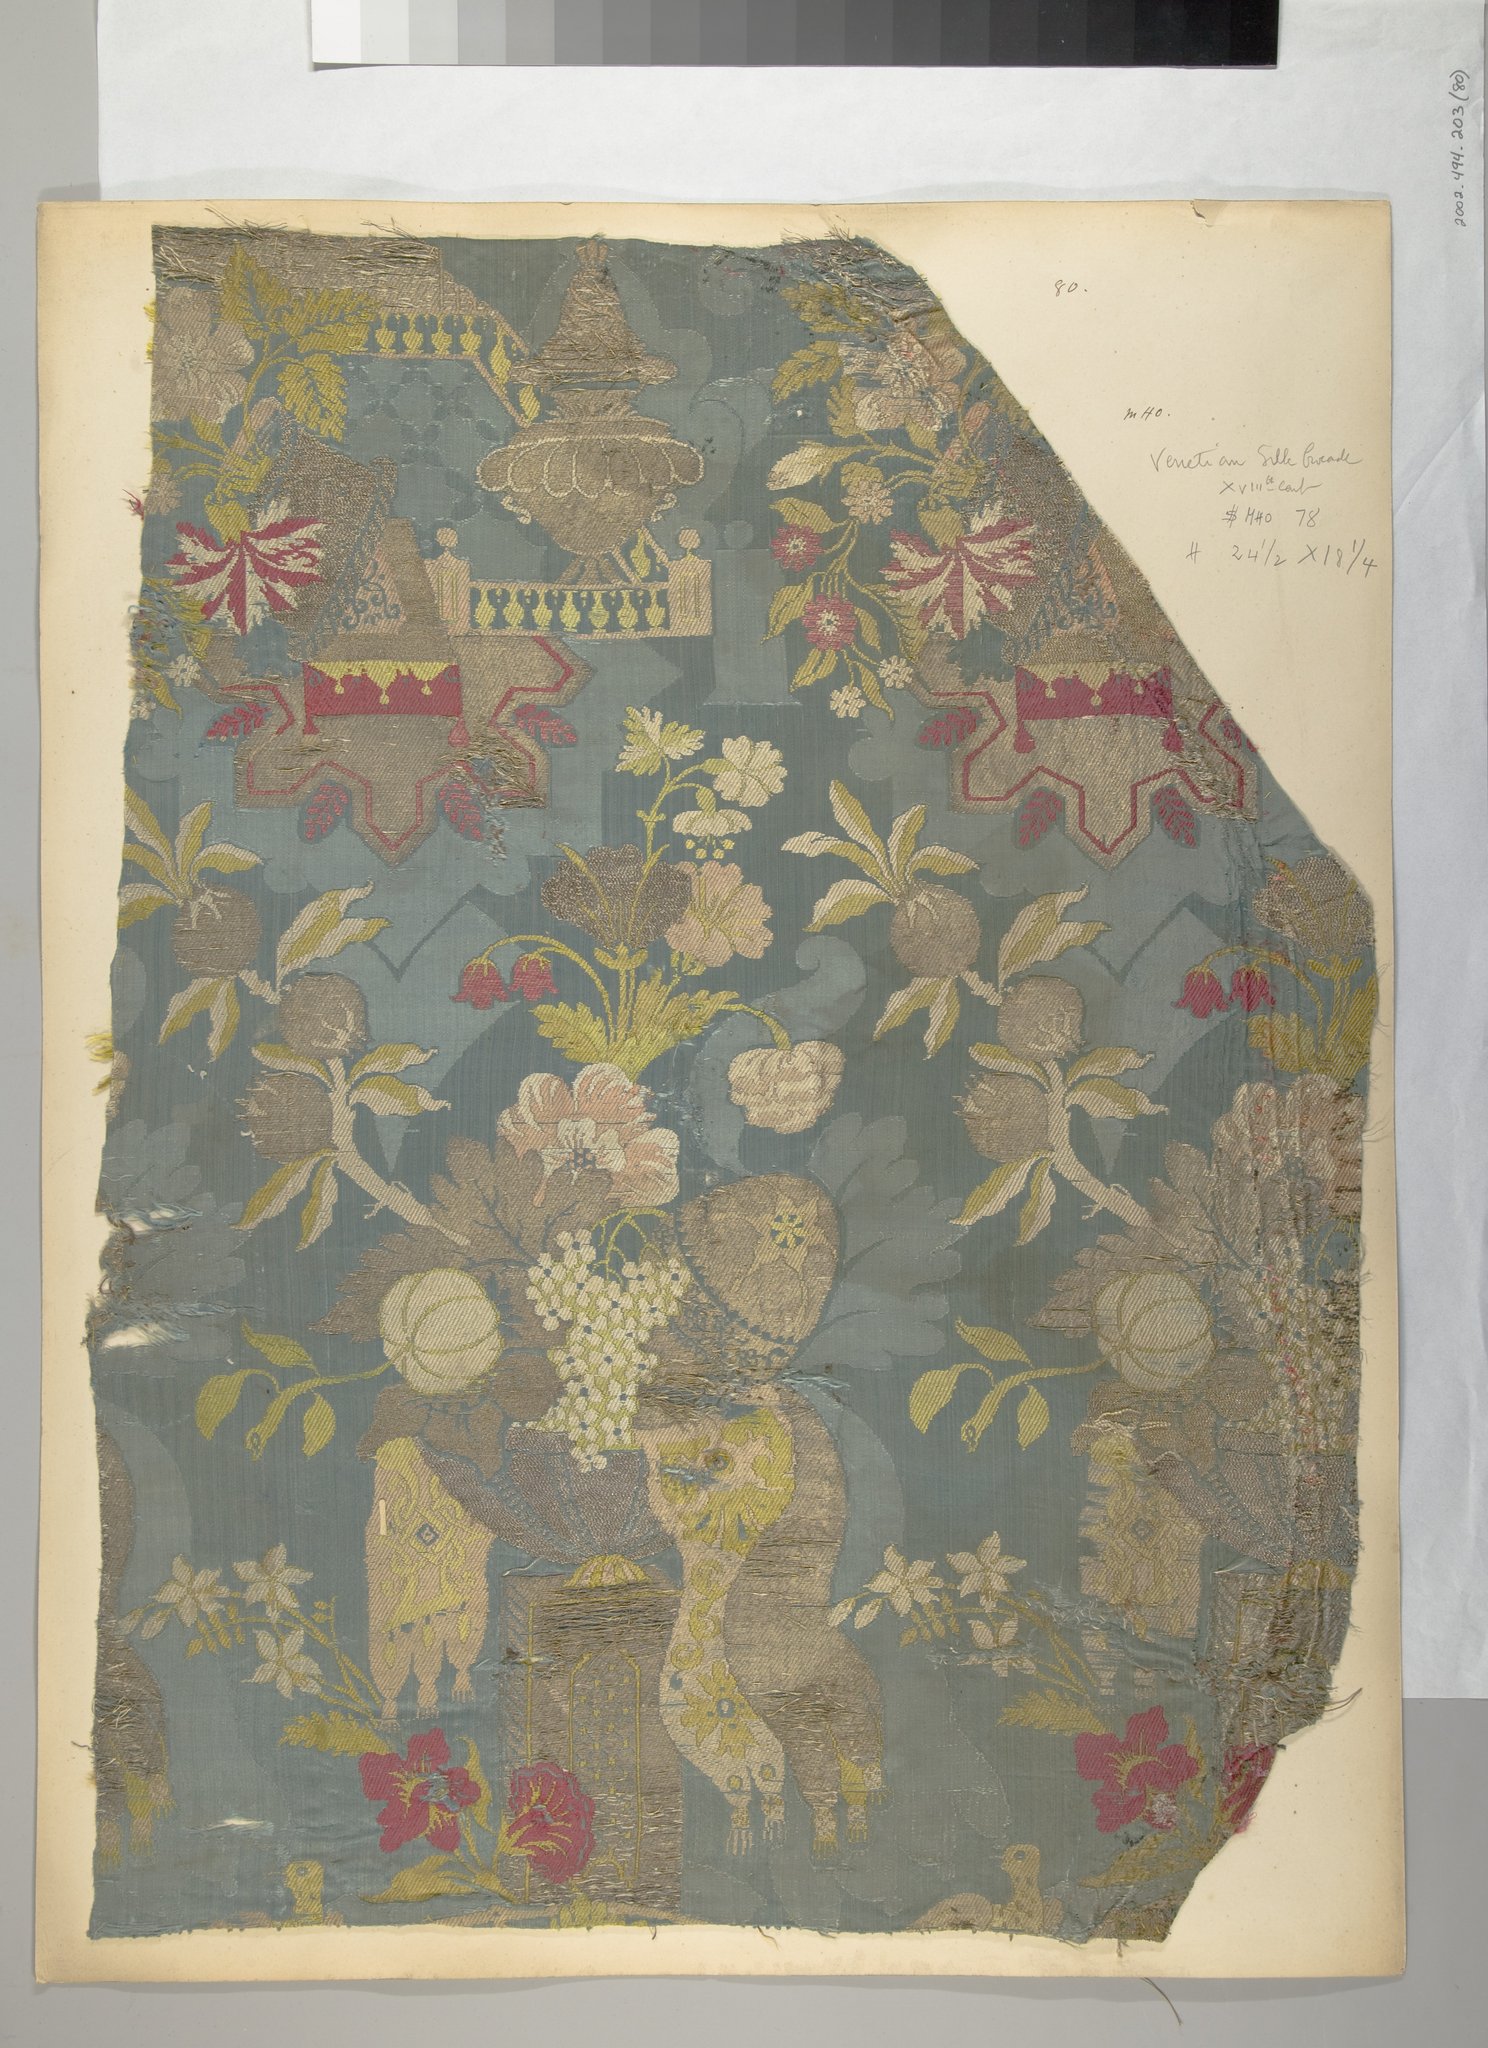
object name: fragment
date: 1701-1800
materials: metal thread, silk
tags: flowers,leaves